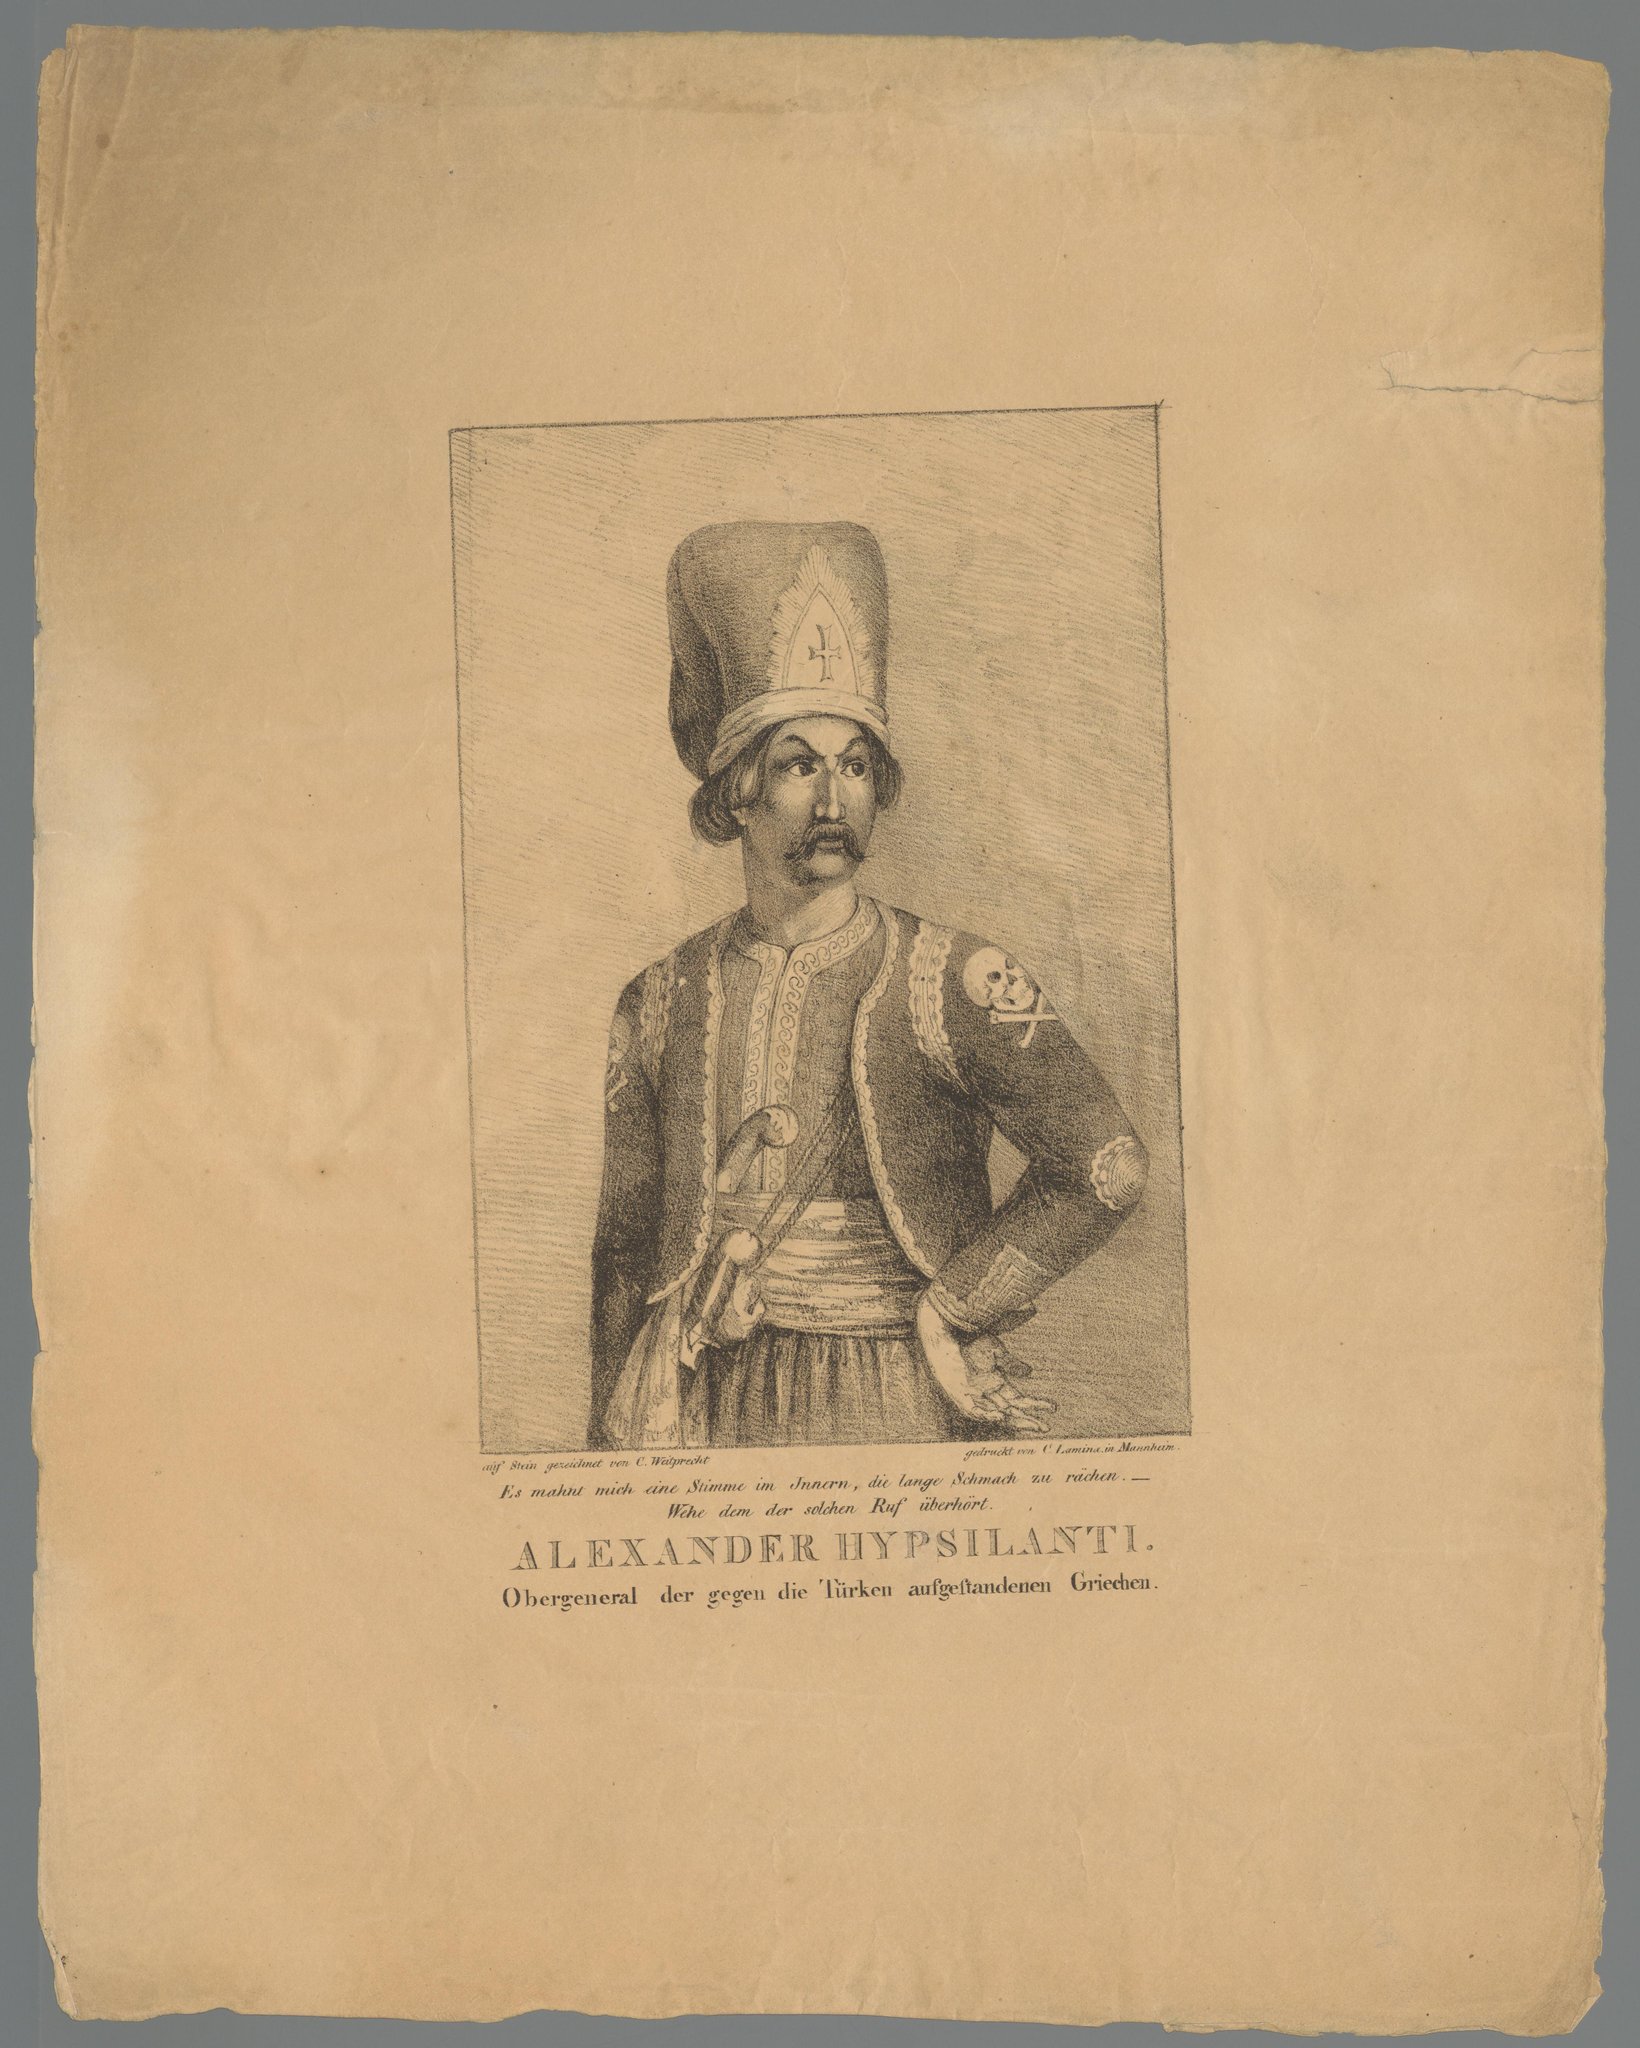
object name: print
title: Alexander Hypsilanti, Obergeneral der gegen die Türken aufgestandenen Griechen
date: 1820-1840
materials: paper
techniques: lithograph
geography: mannheim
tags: head-gear, adult man, historical persons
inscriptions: collector's mark: Lugt 2228